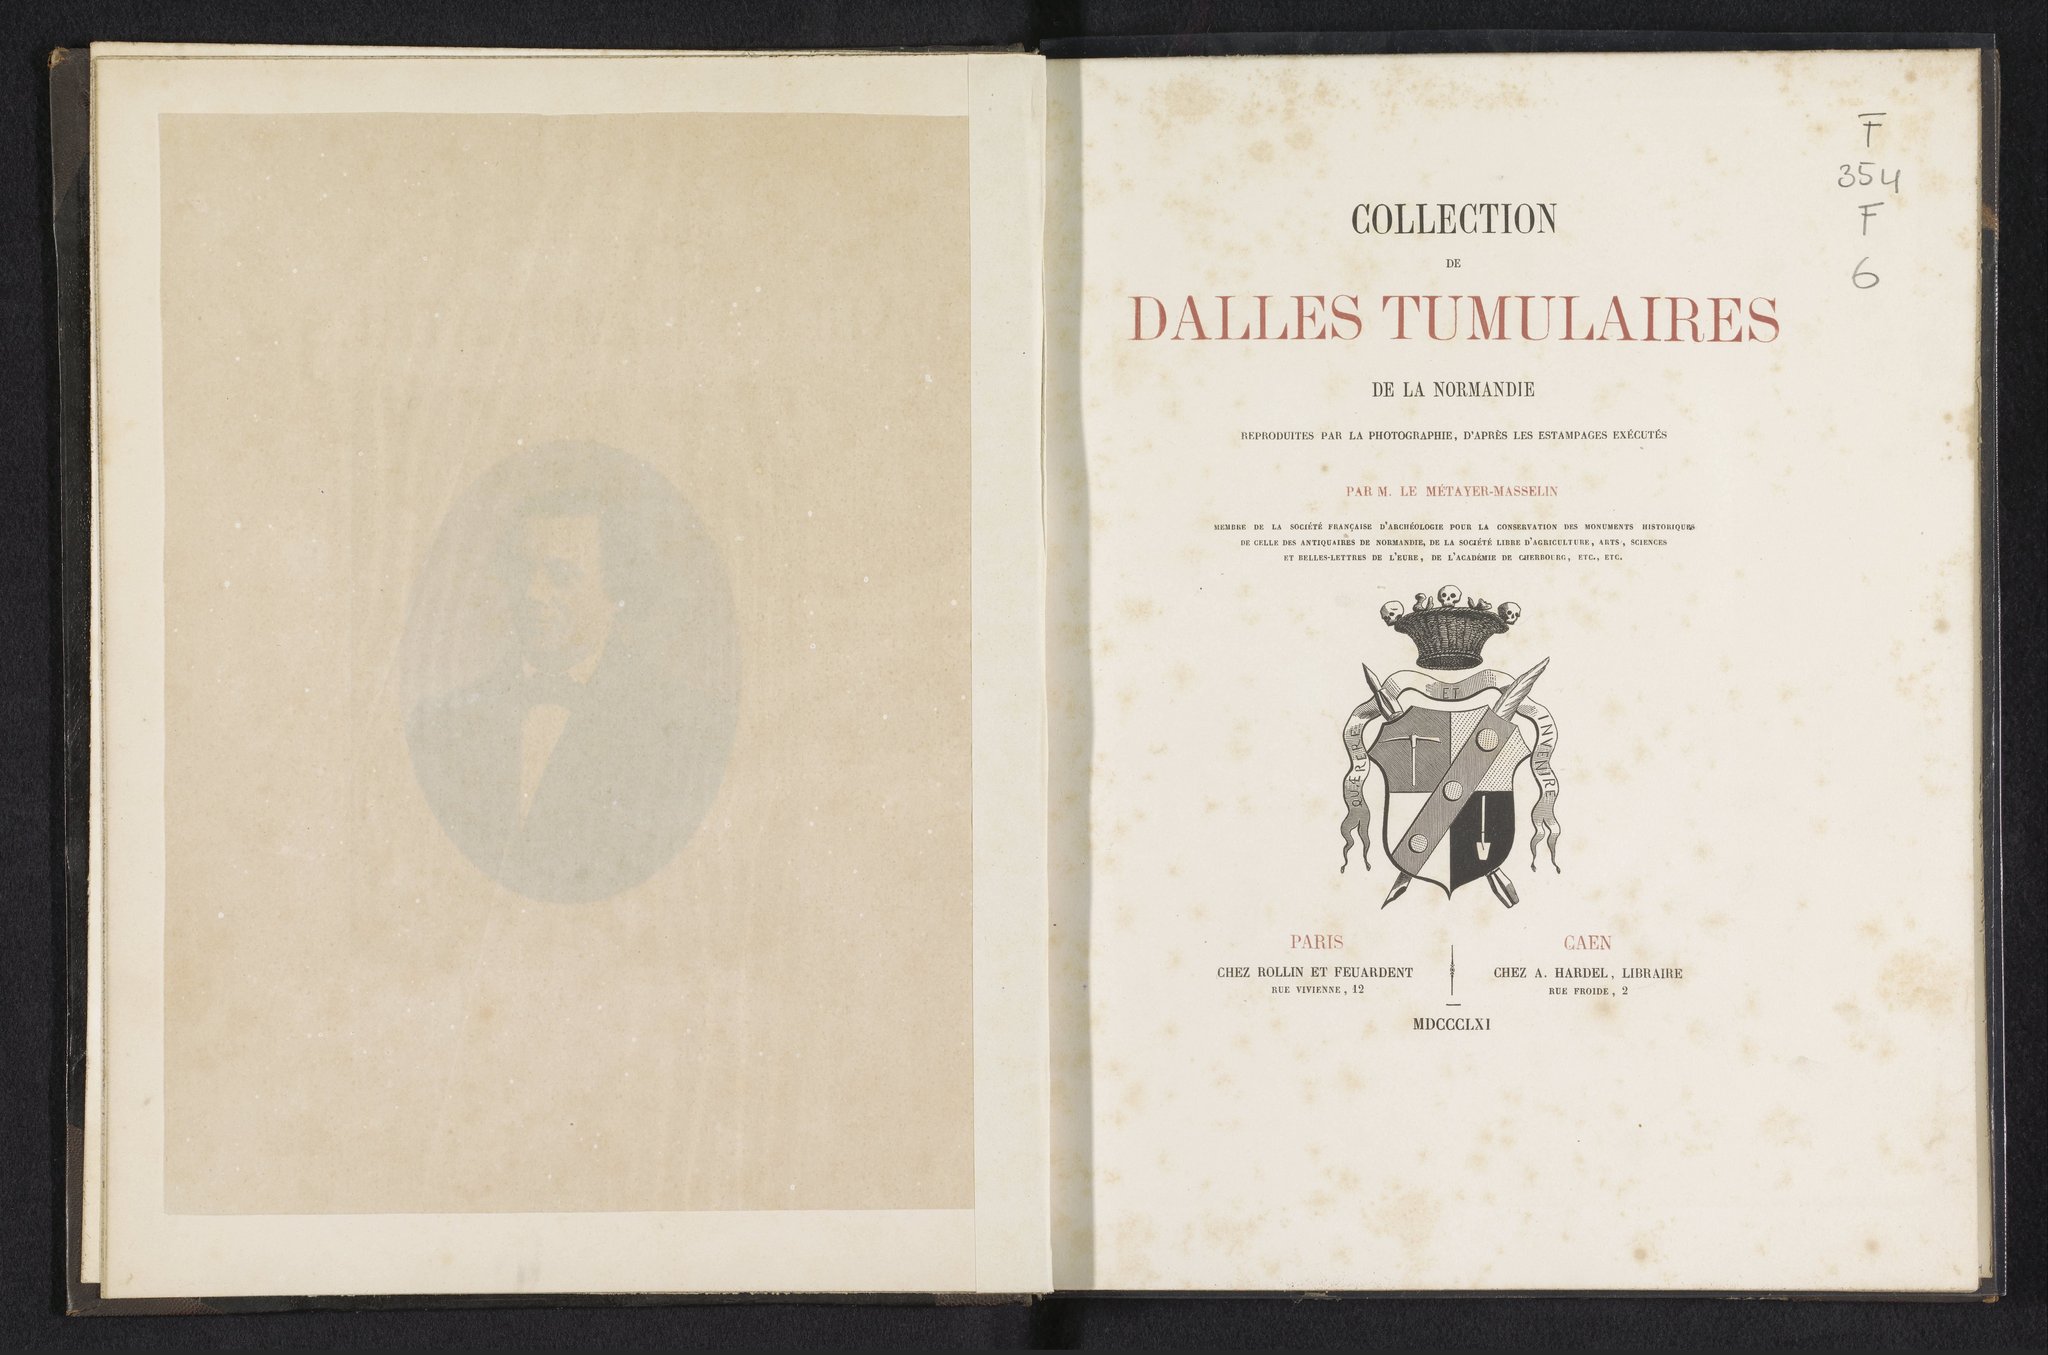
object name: book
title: Collection de dalles tumulaires de la Normandie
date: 1861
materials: leather, paper, photographic support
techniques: albumen print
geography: caen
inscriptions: name: ‘Ex libris Baronis Surmont’